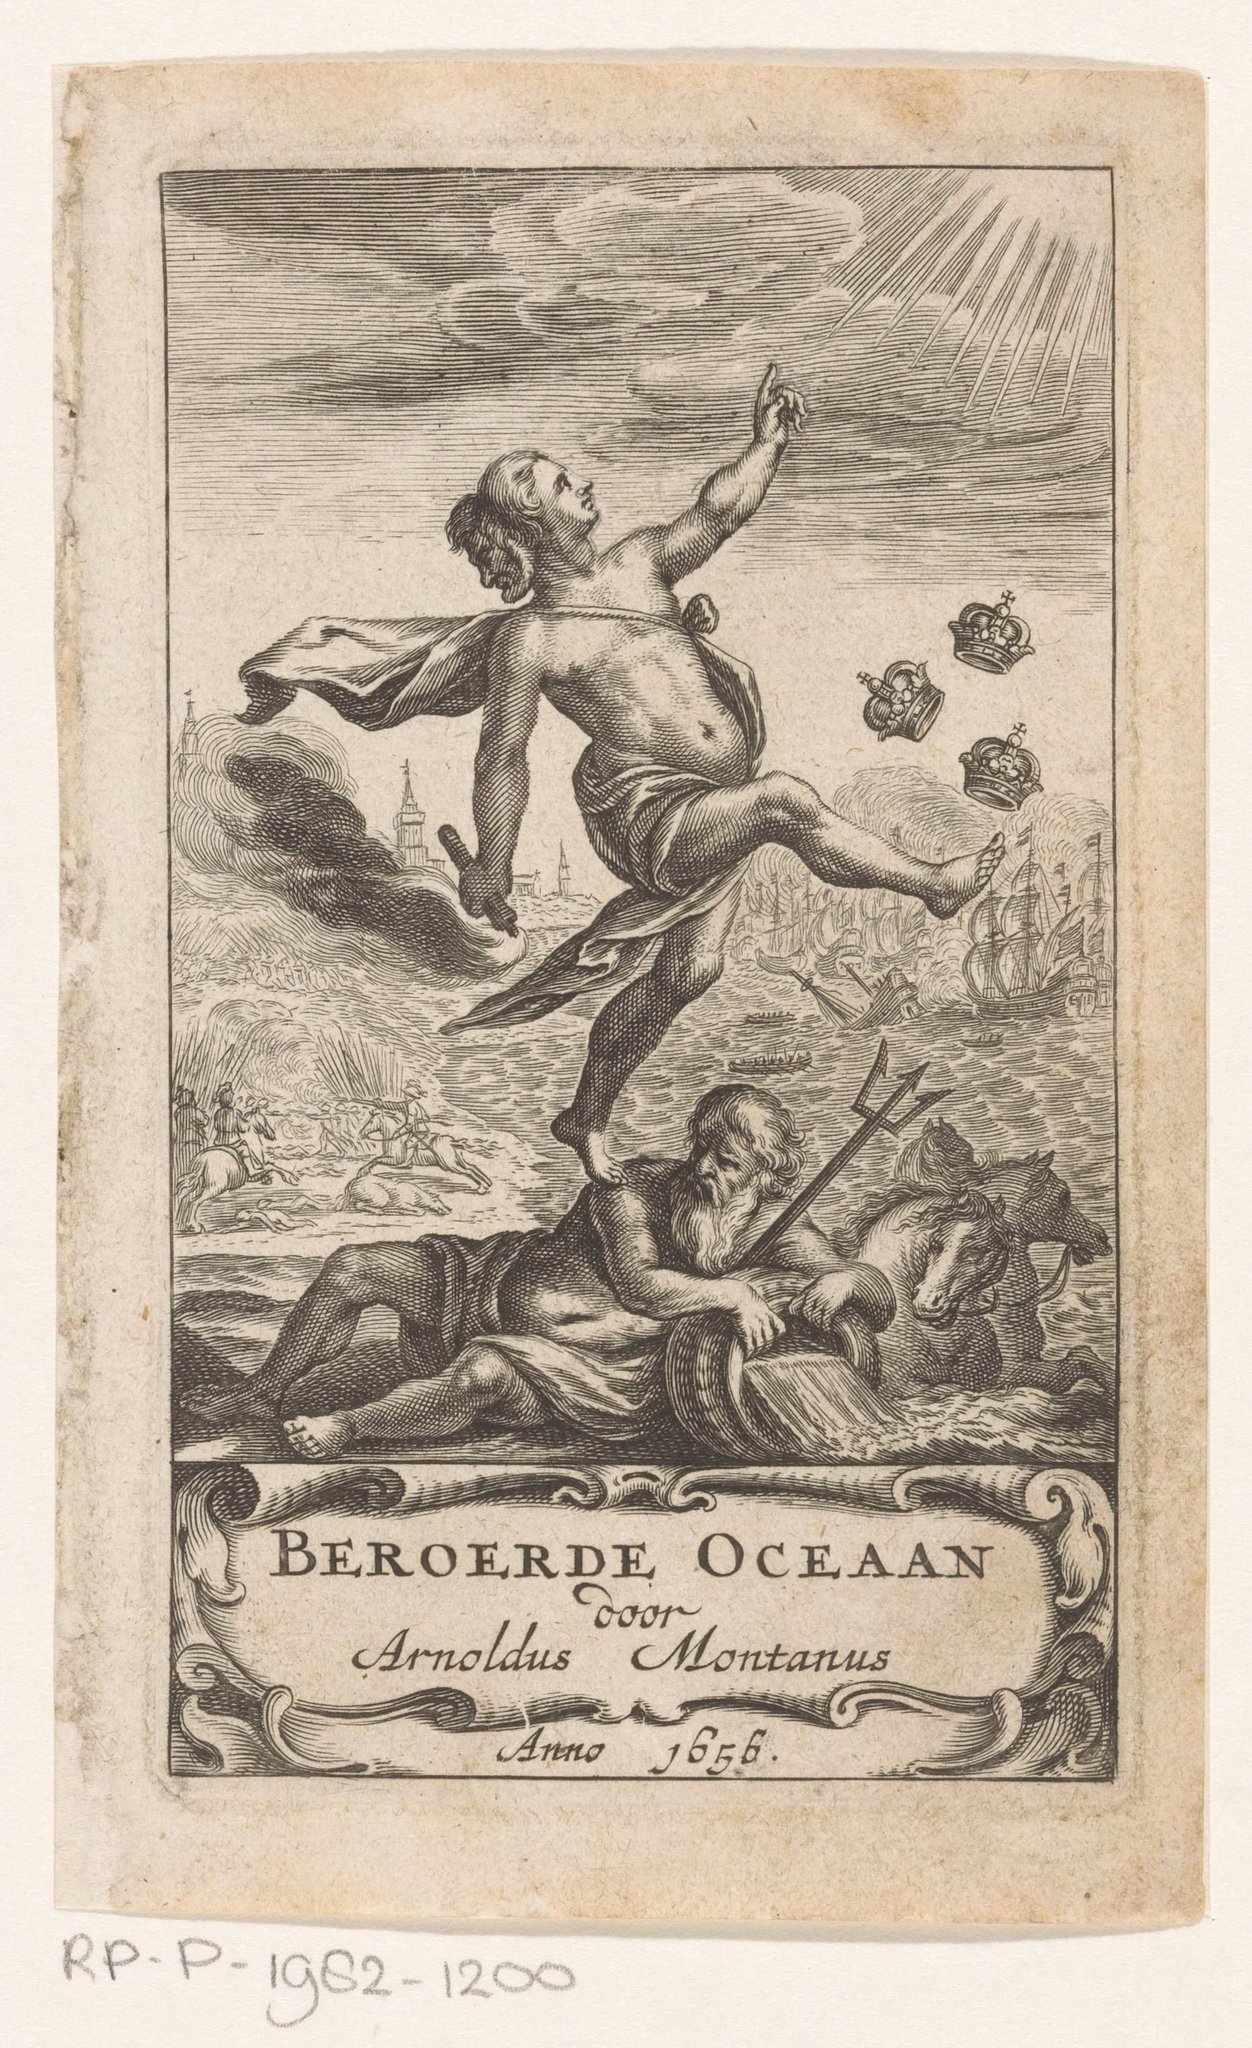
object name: print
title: Titelpagina voor: Arnoldus Montanus, Beroerde Oceaan, 1656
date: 1656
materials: paper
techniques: engraving, etching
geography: amsterdam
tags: crown (symbol of sovereignty), kicking, lower house, parliament, chamber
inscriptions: collector's mark: Lugt 2760, collector's mark: Lugt 2228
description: Titelpagina voor: Montanus, Arnoldus. De beroerde oceaan, of Twee-jaarige zee-daaden der Vereenigde Nederlanders en Engelsche. Amsterdam: Valckenier, Gillis Janssen, 1656.